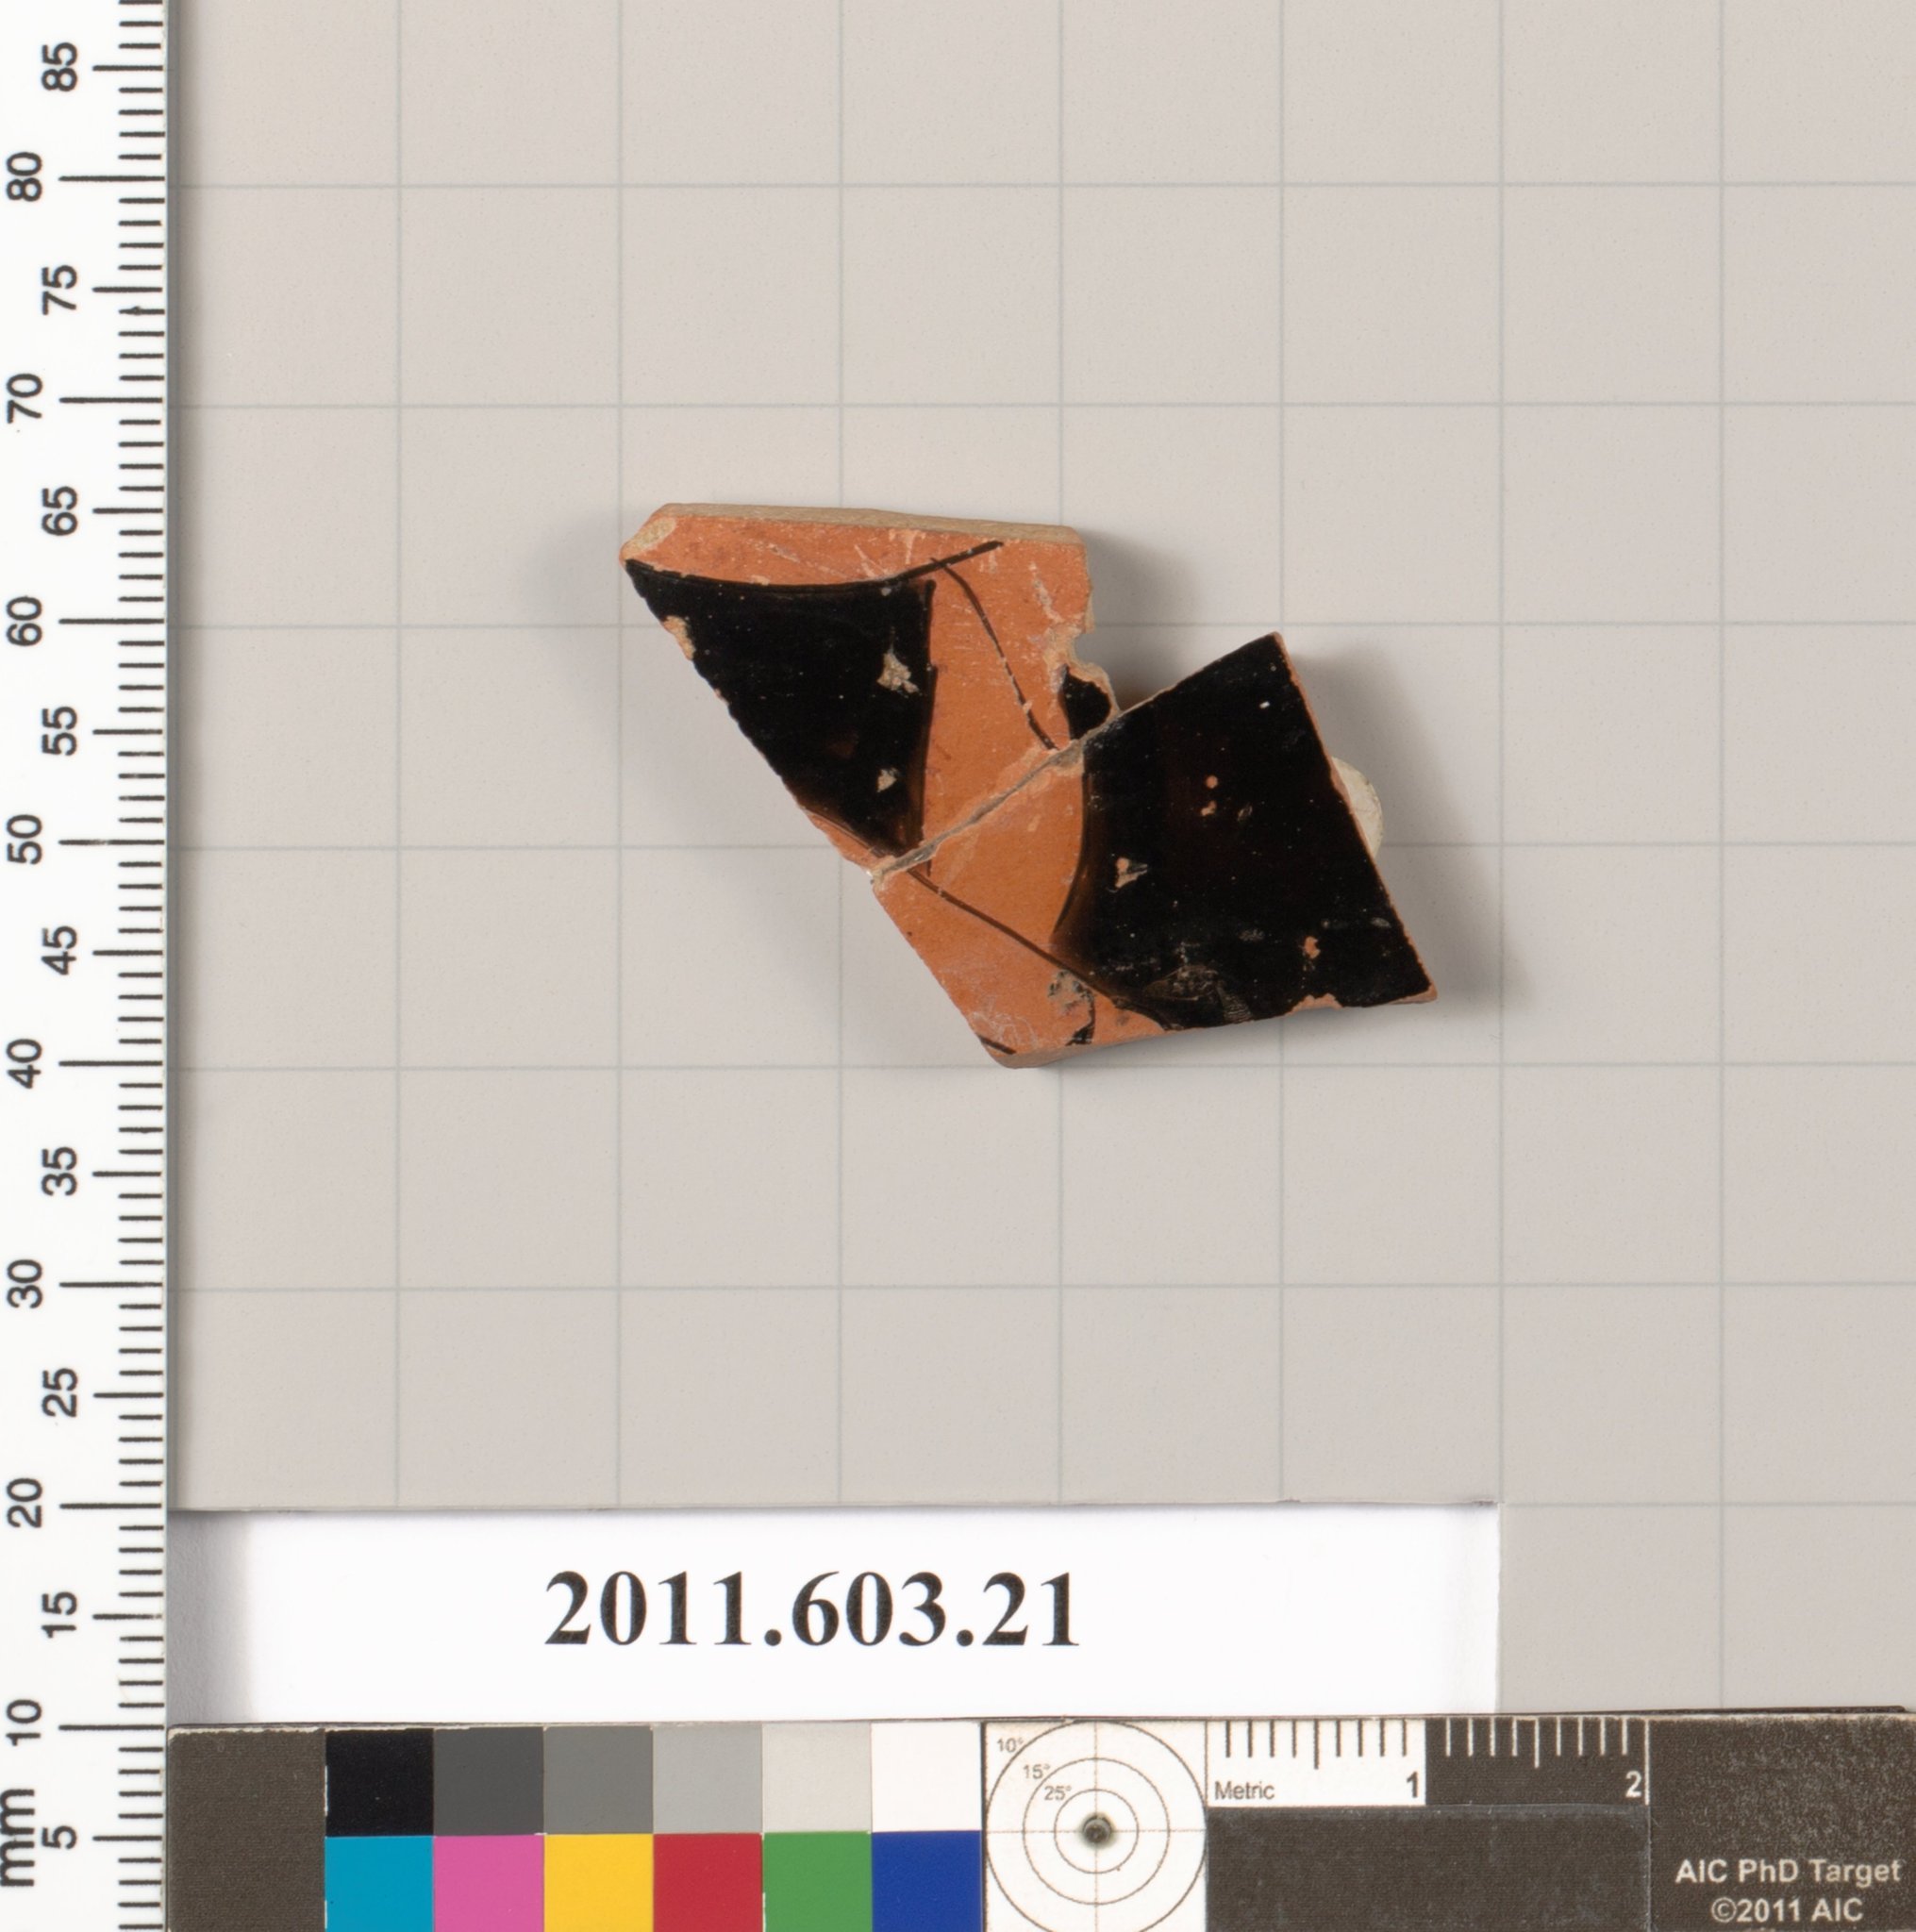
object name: kylix fragment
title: Fragment of a terracotta kylix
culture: greek, attic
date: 534-468 BCE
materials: terracotta